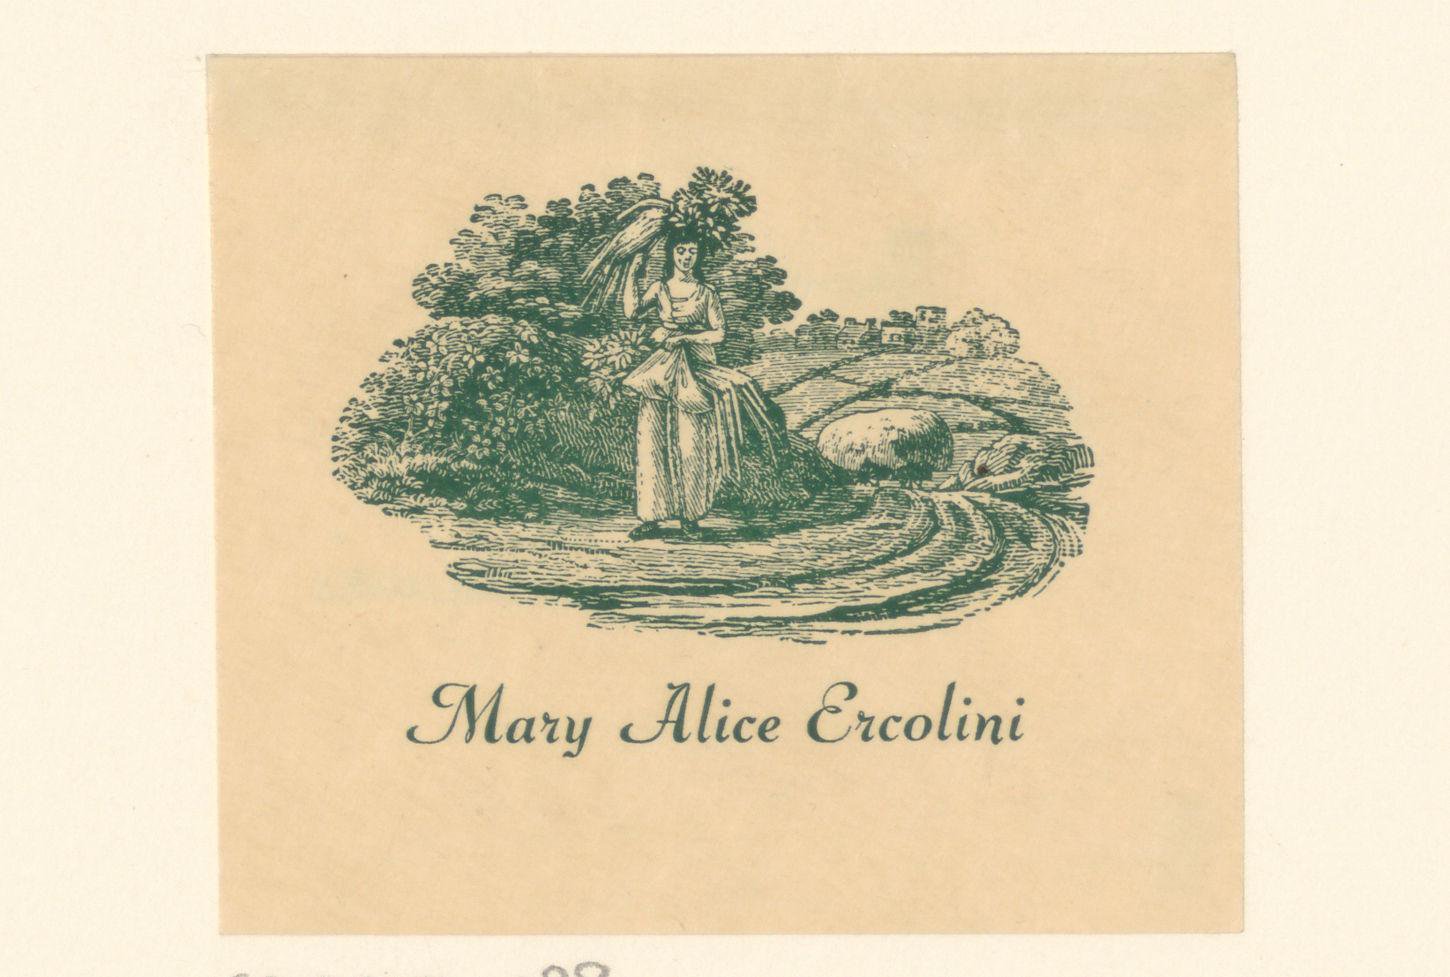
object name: print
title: Ex libris van Mary Alice Ercolini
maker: thomas bewick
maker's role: draughtsman, painter, print maker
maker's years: 1753-1828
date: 1768-1828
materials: paper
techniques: engraving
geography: great britain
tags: mary alice ercolini, predatory birds: falcon, dale, valley